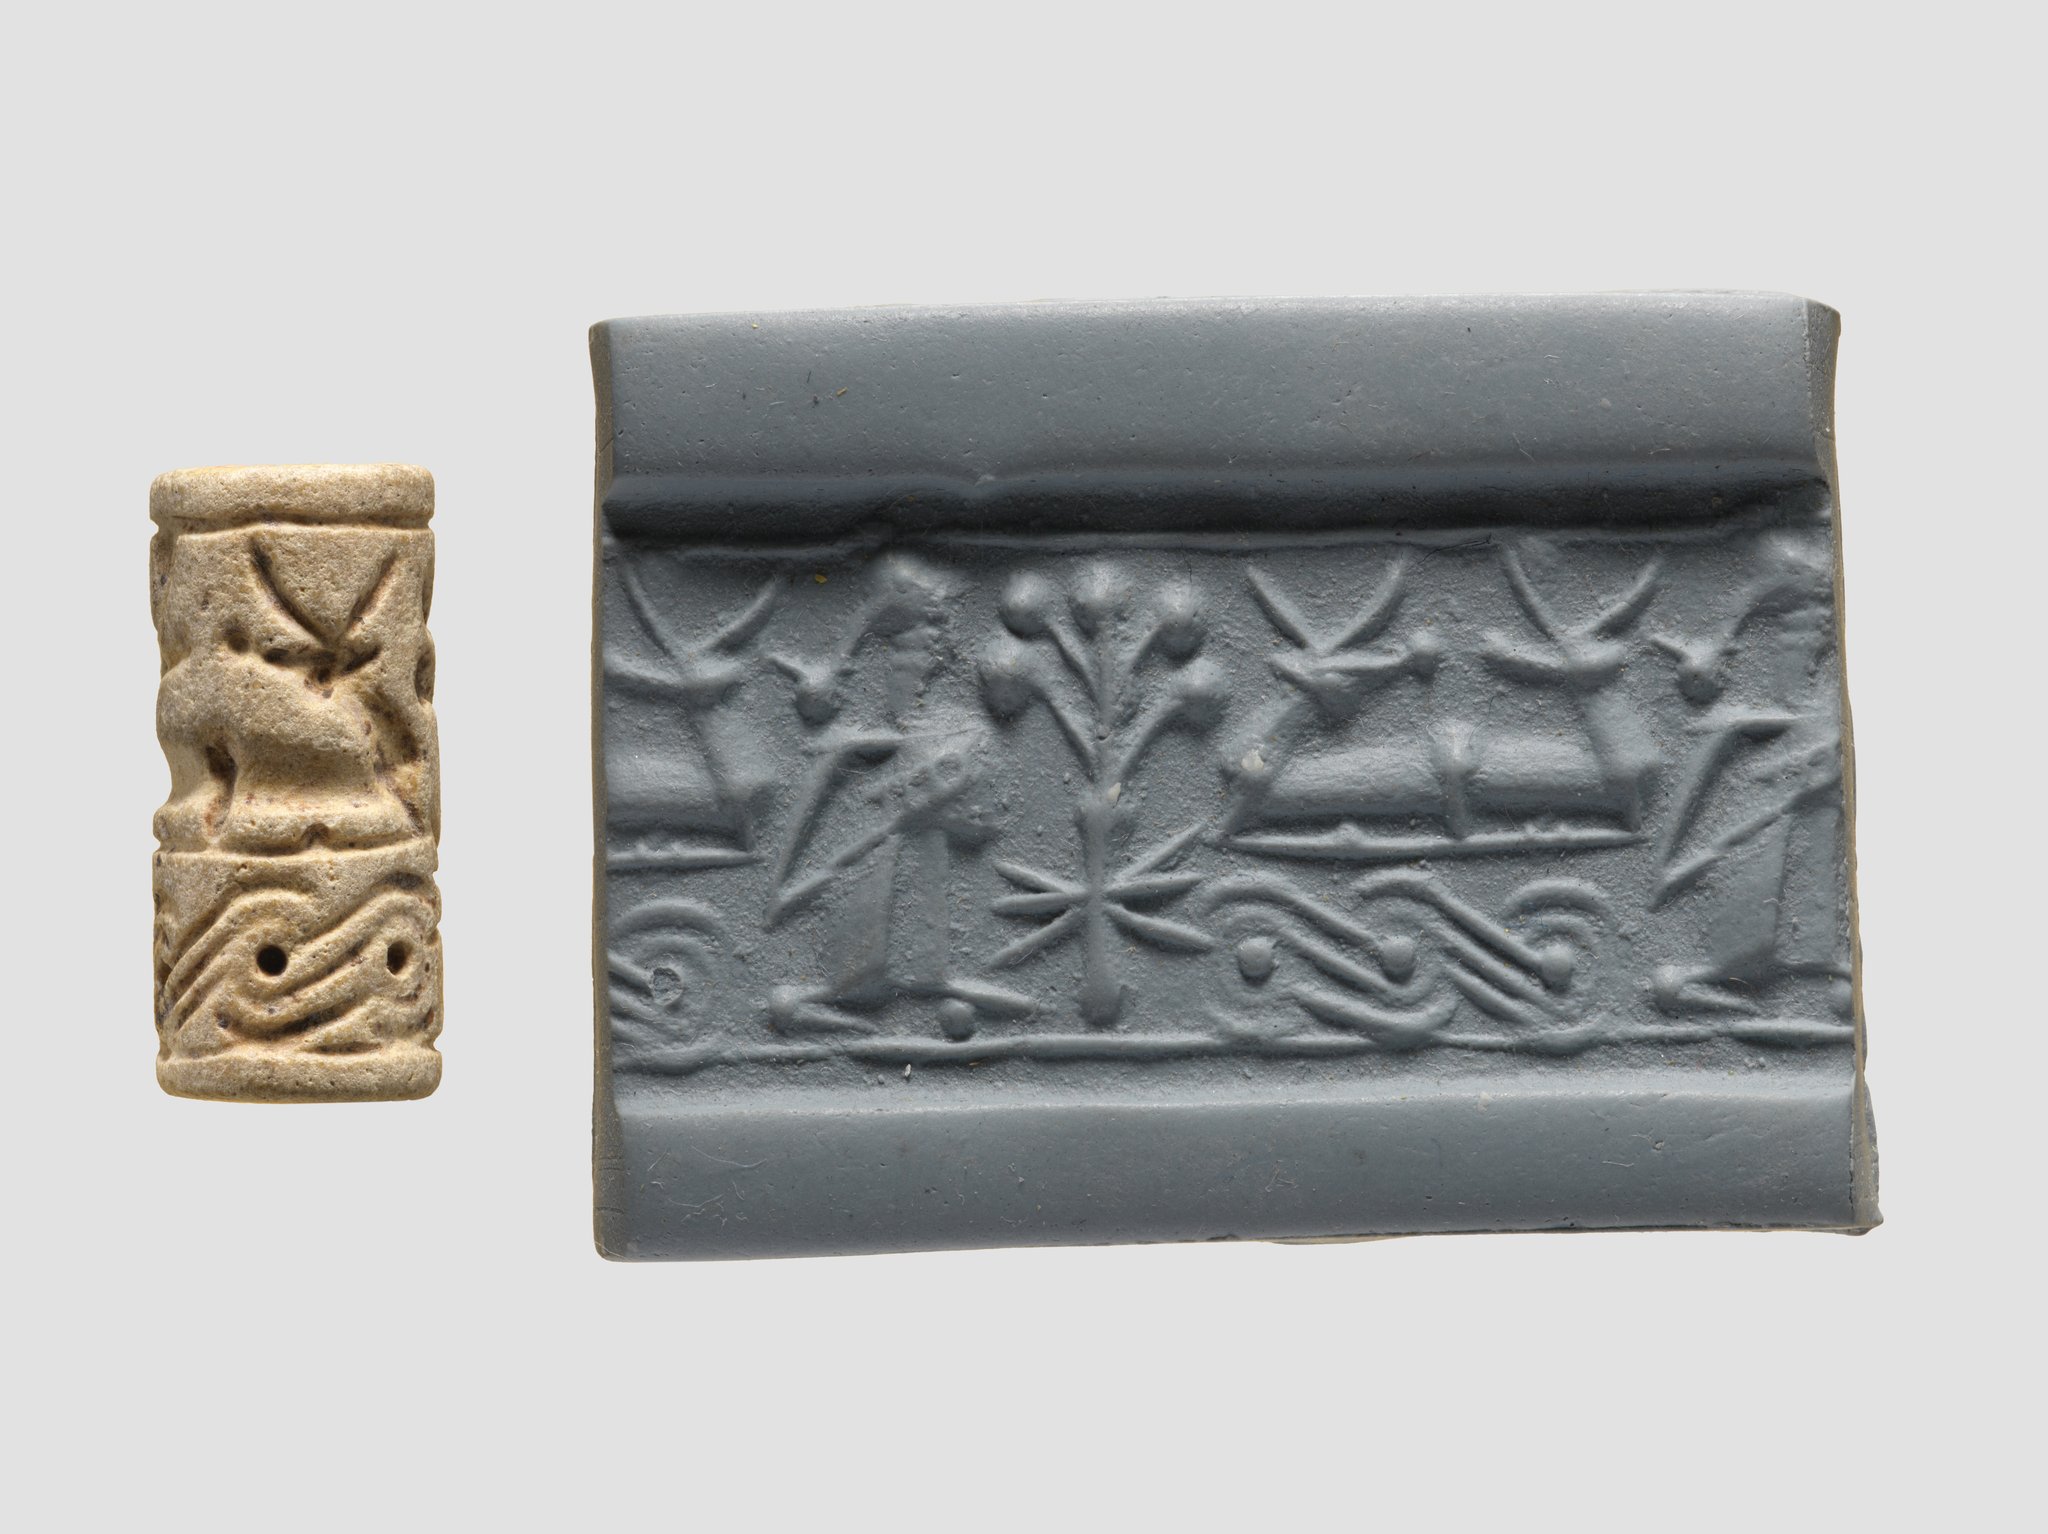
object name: cylinder seal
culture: mitanni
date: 1500-1301 BCE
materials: faience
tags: men,trees